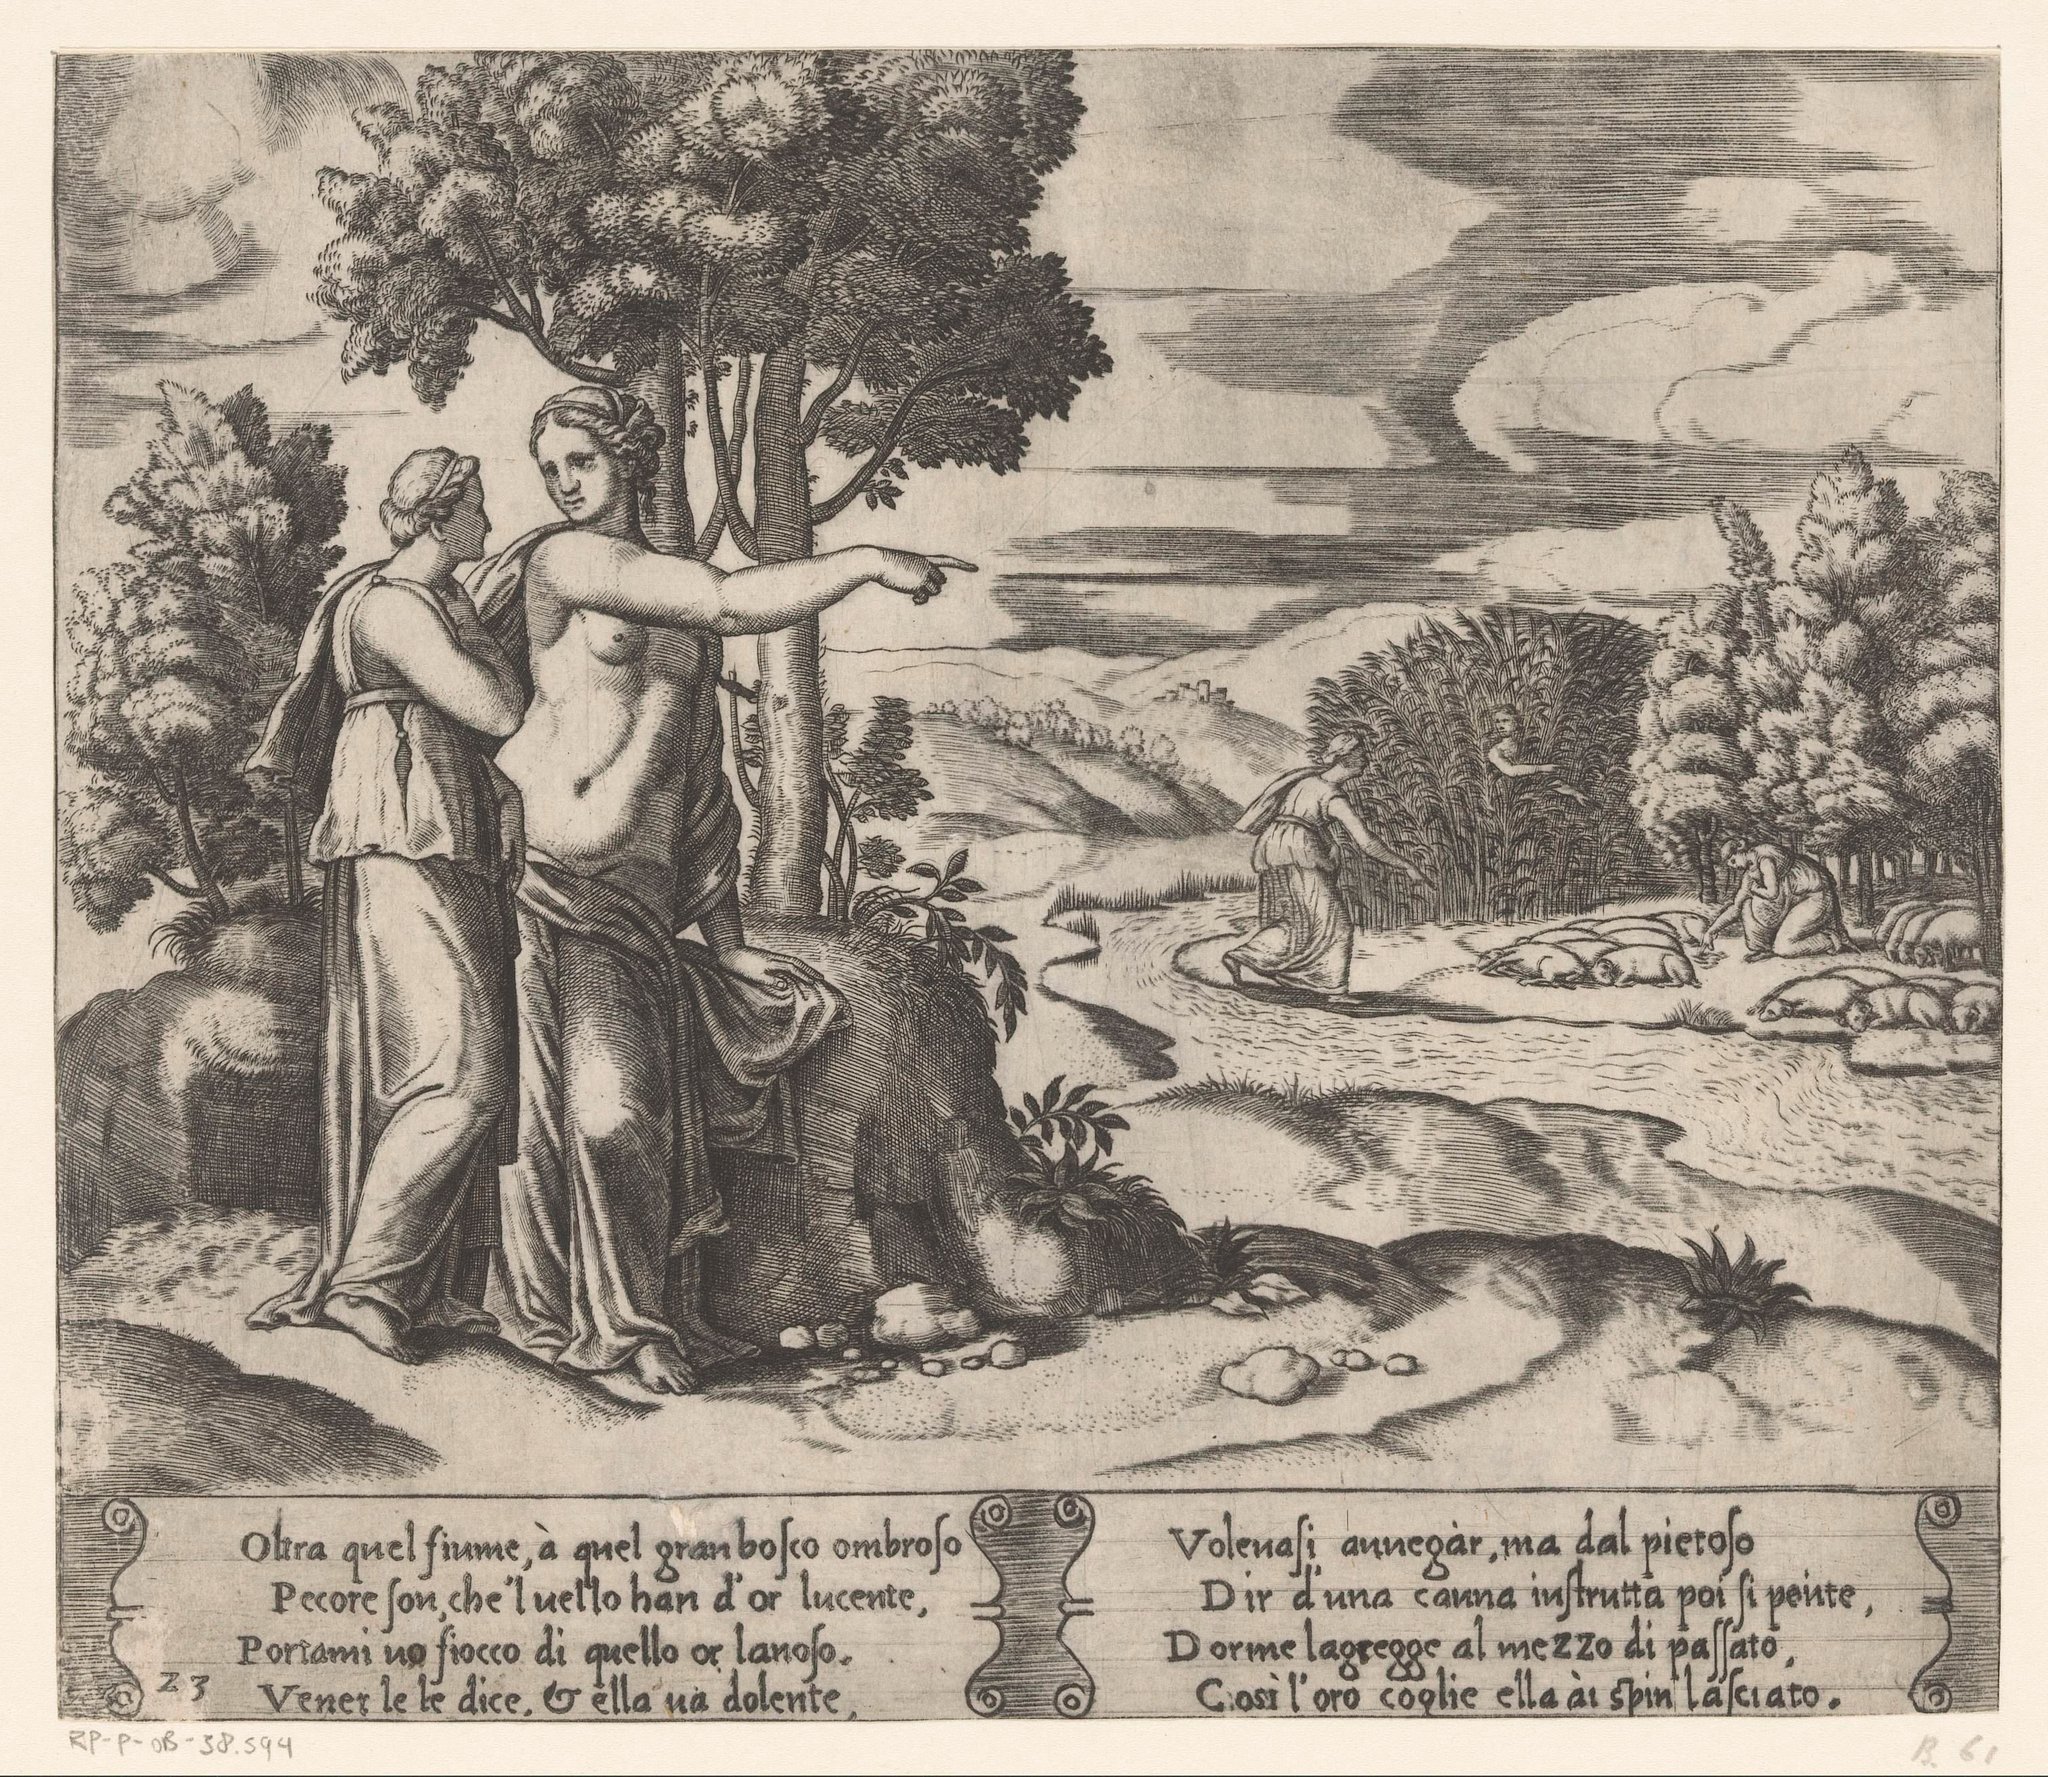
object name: print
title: Verhaal van Amor en Psyche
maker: meester van de dobbelsteen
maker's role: print maker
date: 1530-1560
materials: paper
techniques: engraving, intaglio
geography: italy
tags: psyche, being directed by the reeds, collects the golden wool from the sheep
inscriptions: collector's mark: Lugt 2228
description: Venus draagt Psyche op om wol te verzamelen van een kudde schapen met een gouden vacht. Links wijst Venus Psyche naar de schapen aan de overkant van een rivier. Rechts Psyche bij de schapen en tussen het riet dat haar fluisterend adviseerde over hoe de wol te verzamelen. Italiaanse tekst in twee cartouches in ondermarge. Tweemaal genummerd linksonder: 23.